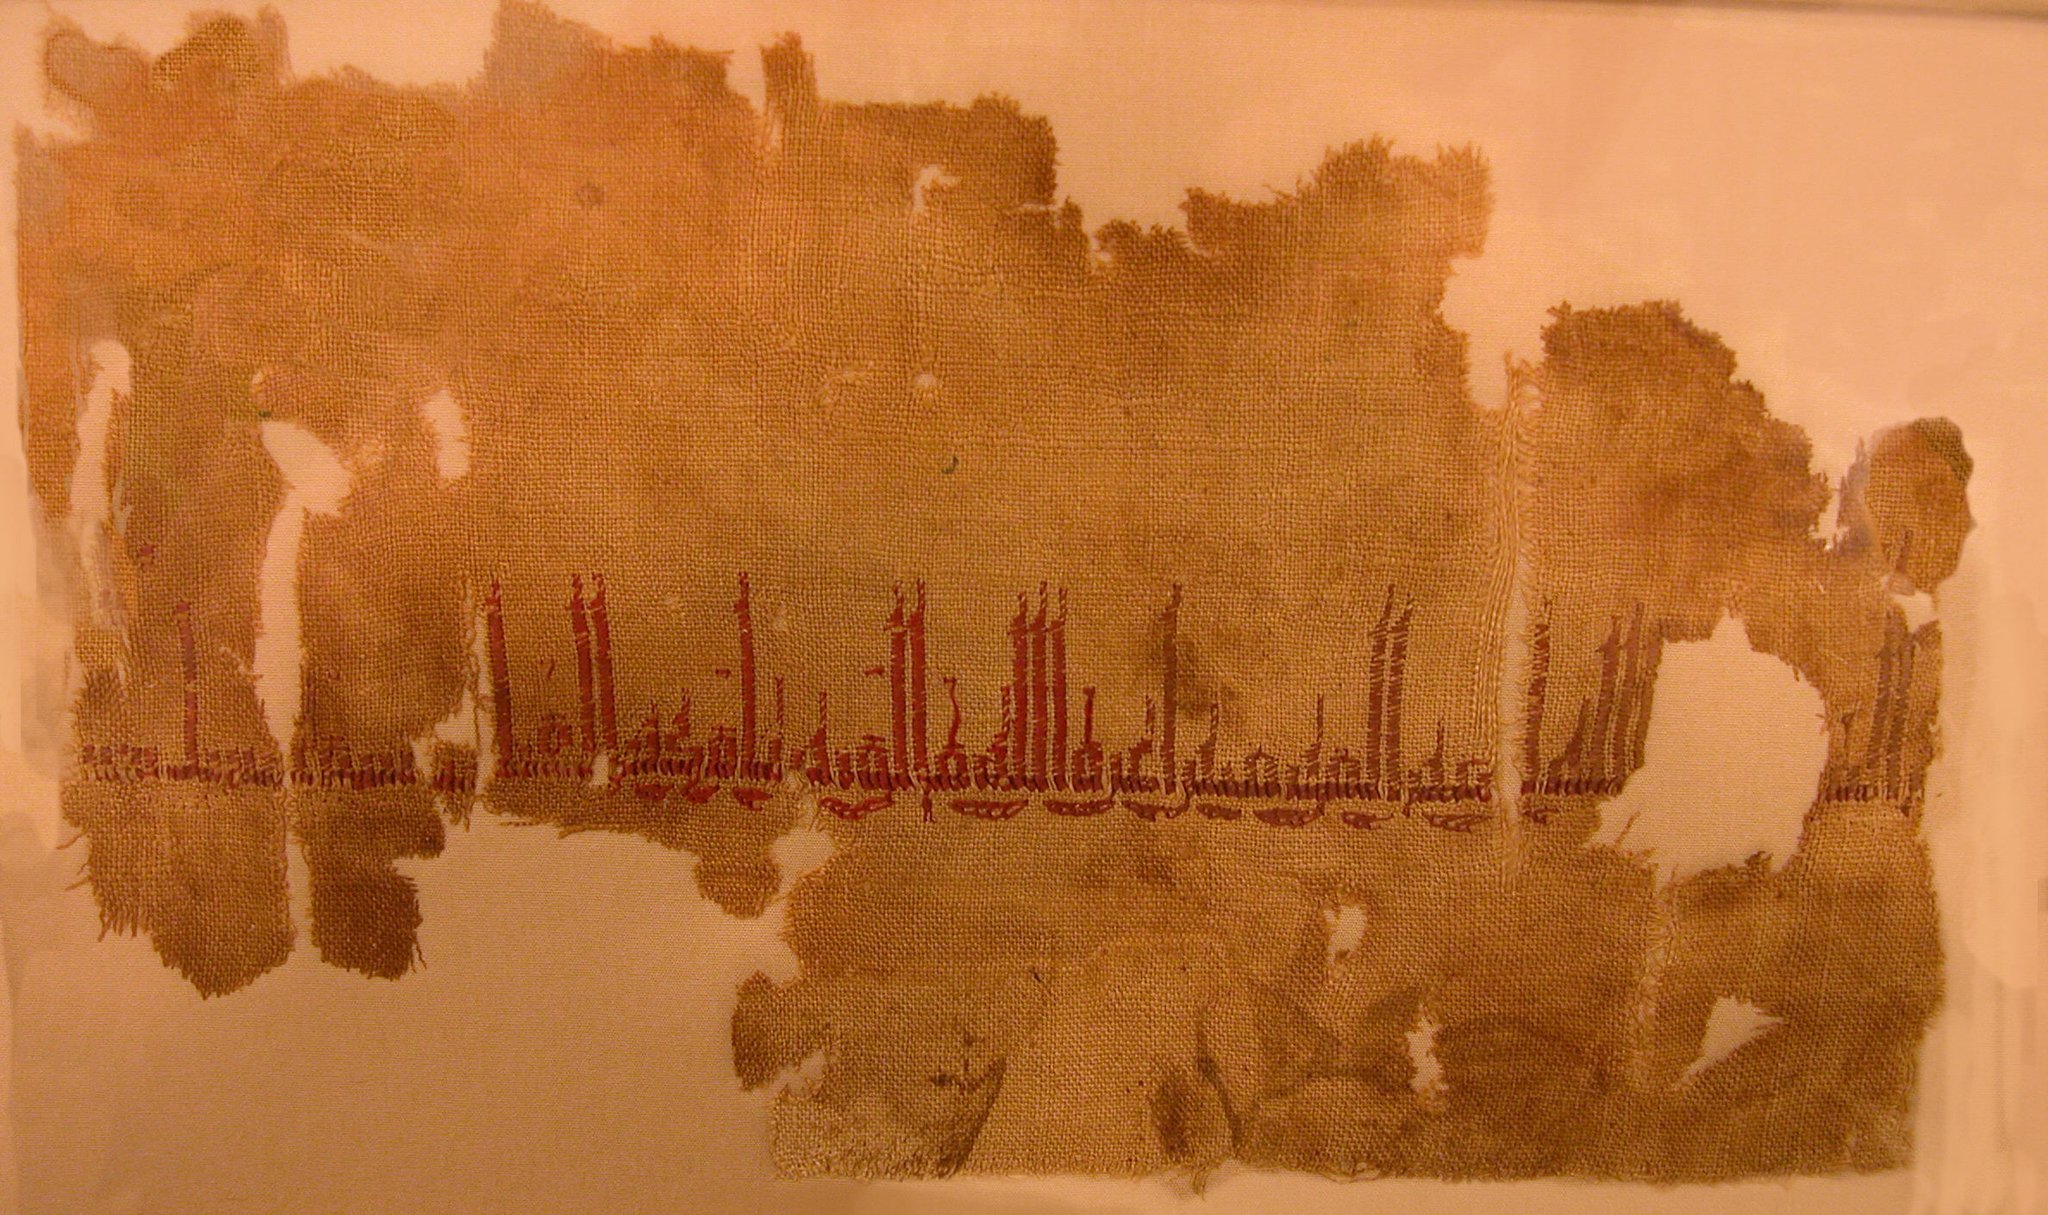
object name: textile fragment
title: Tiraz Fragment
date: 918-923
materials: linen, silk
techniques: embroidery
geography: egypt